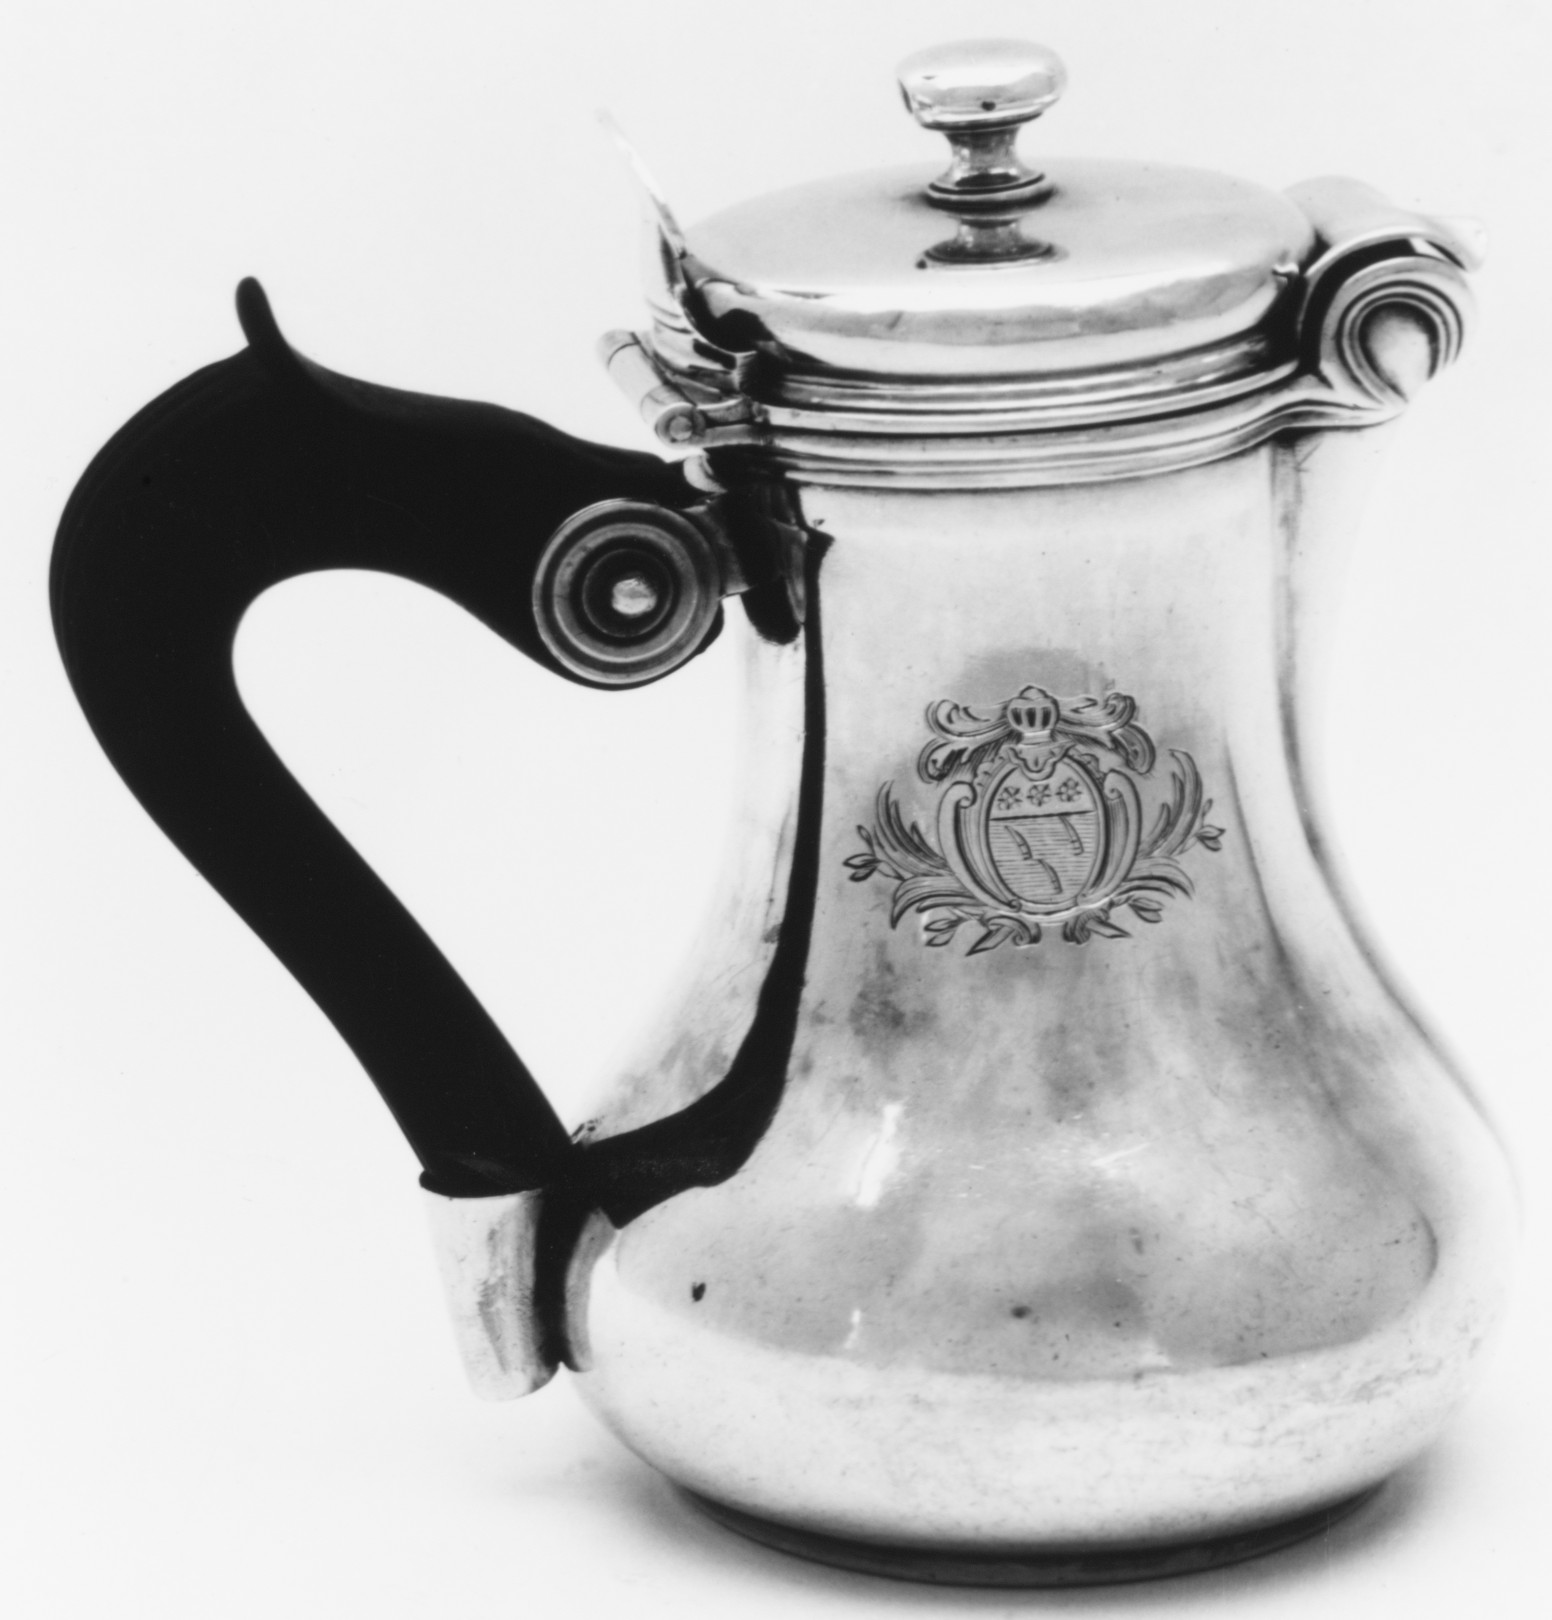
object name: hot milk pot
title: Hot milk pot (?)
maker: jean-louis-dieudonné outrebon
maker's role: maker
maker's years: 1742-1819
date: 1778-1779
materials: wood, silver